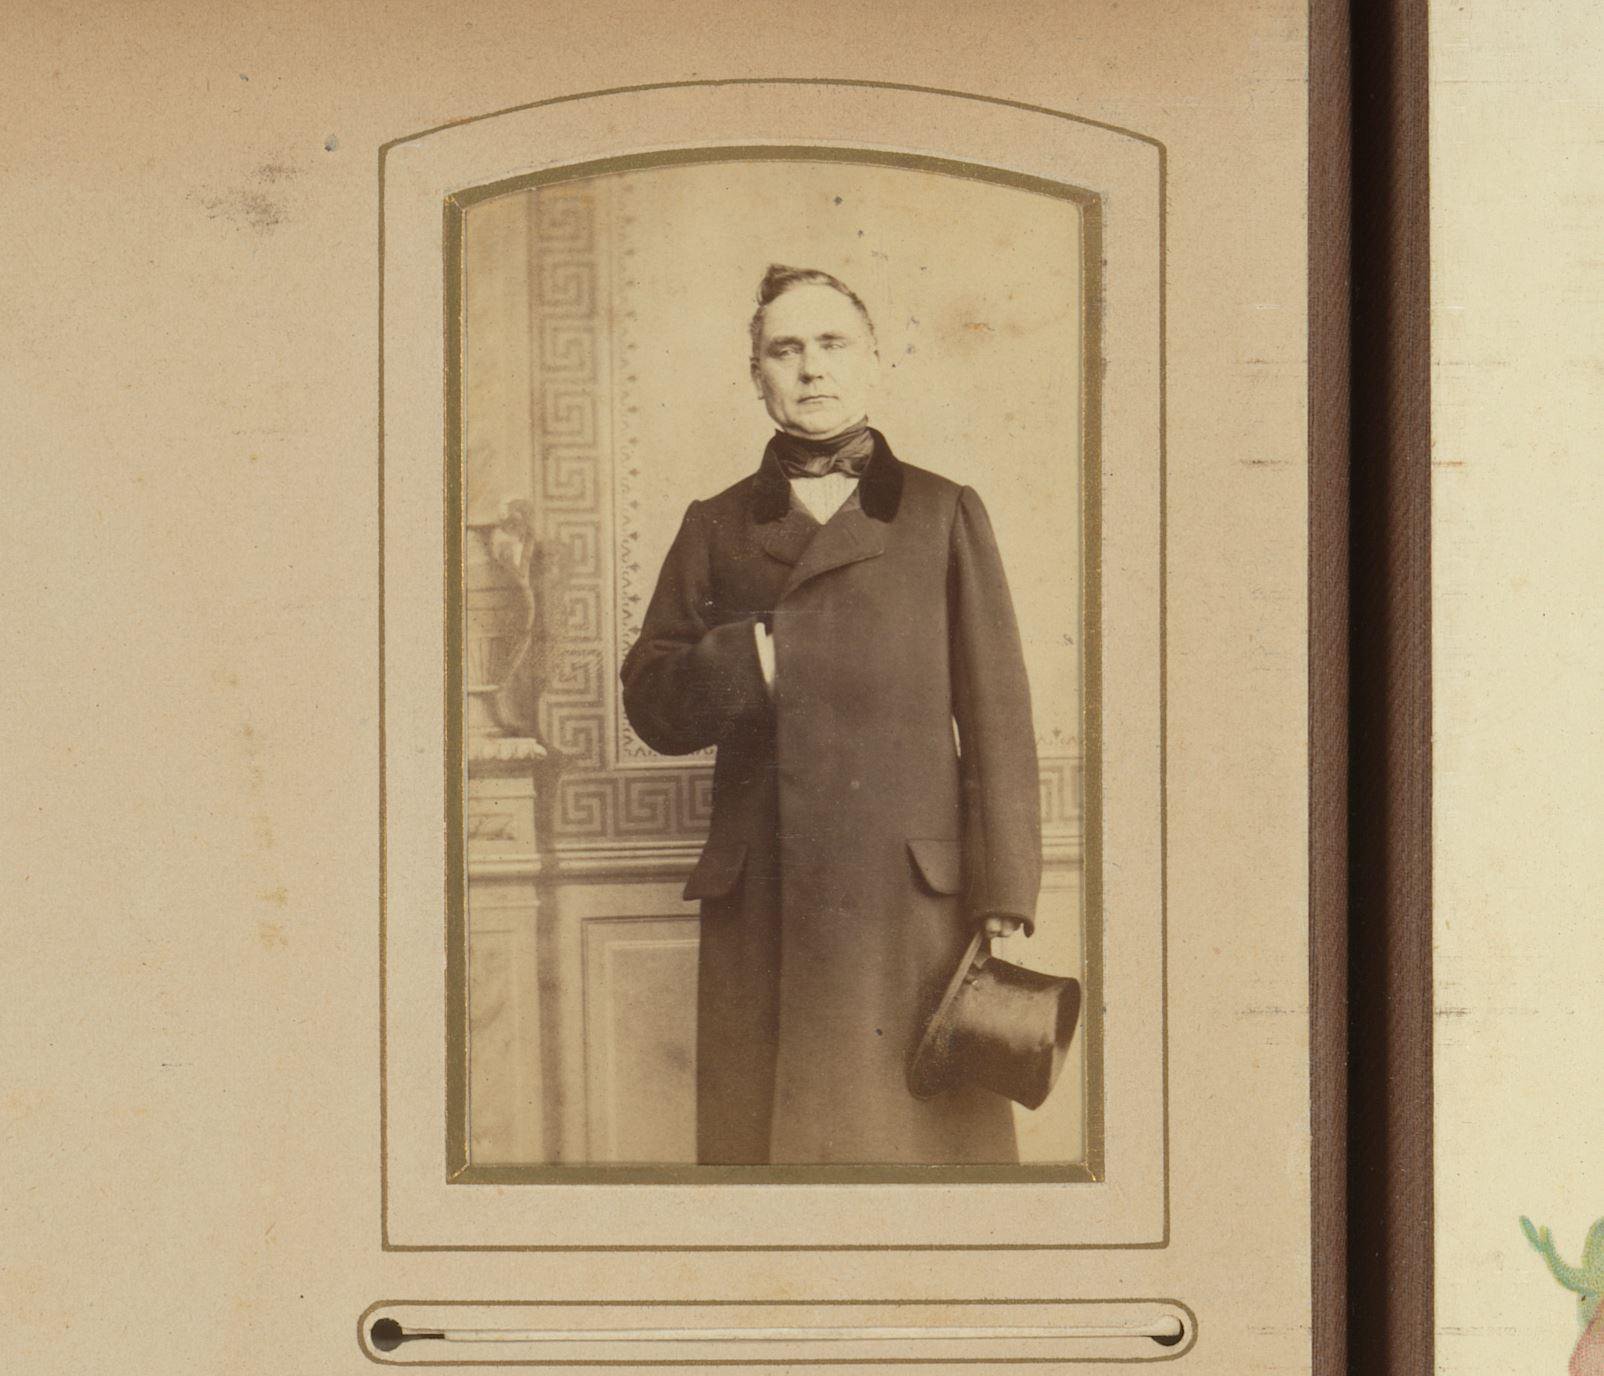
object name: carte de visite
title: Portret van een staande man met hoge hoed in de hand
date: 1863-1870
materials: cardboard, photographic support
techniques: albumen print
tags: standing figure, historical persons, head-gear: top hat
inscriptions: annotation: ‘H Blanckart phot. à Hasselt & St Trond’